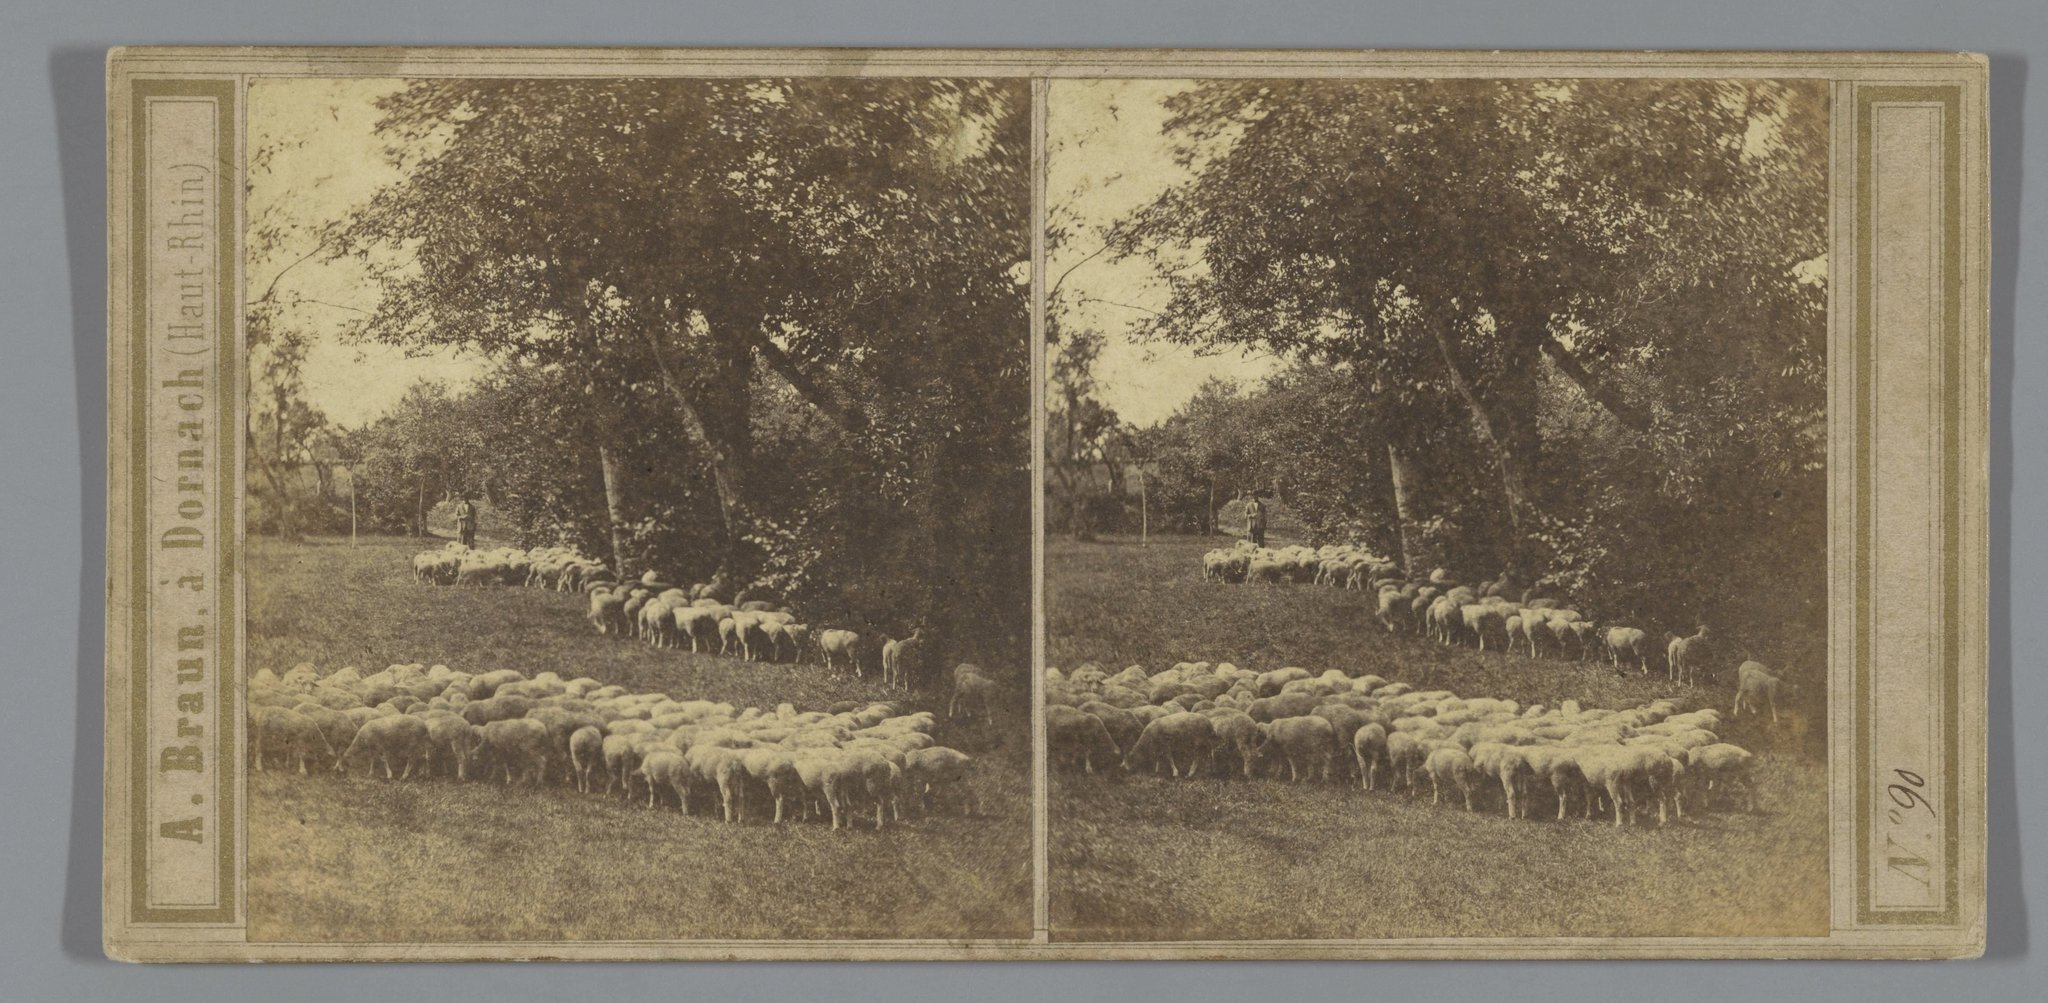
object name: stereograph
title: Schaapsherder met kudde schapen op een weide, mogelijk in Duitsland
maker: Anonymous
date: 1860-1866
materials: cardboard, paper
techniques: albumen print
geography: dornach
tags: herd, flock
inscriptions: number: ‘No. 90’